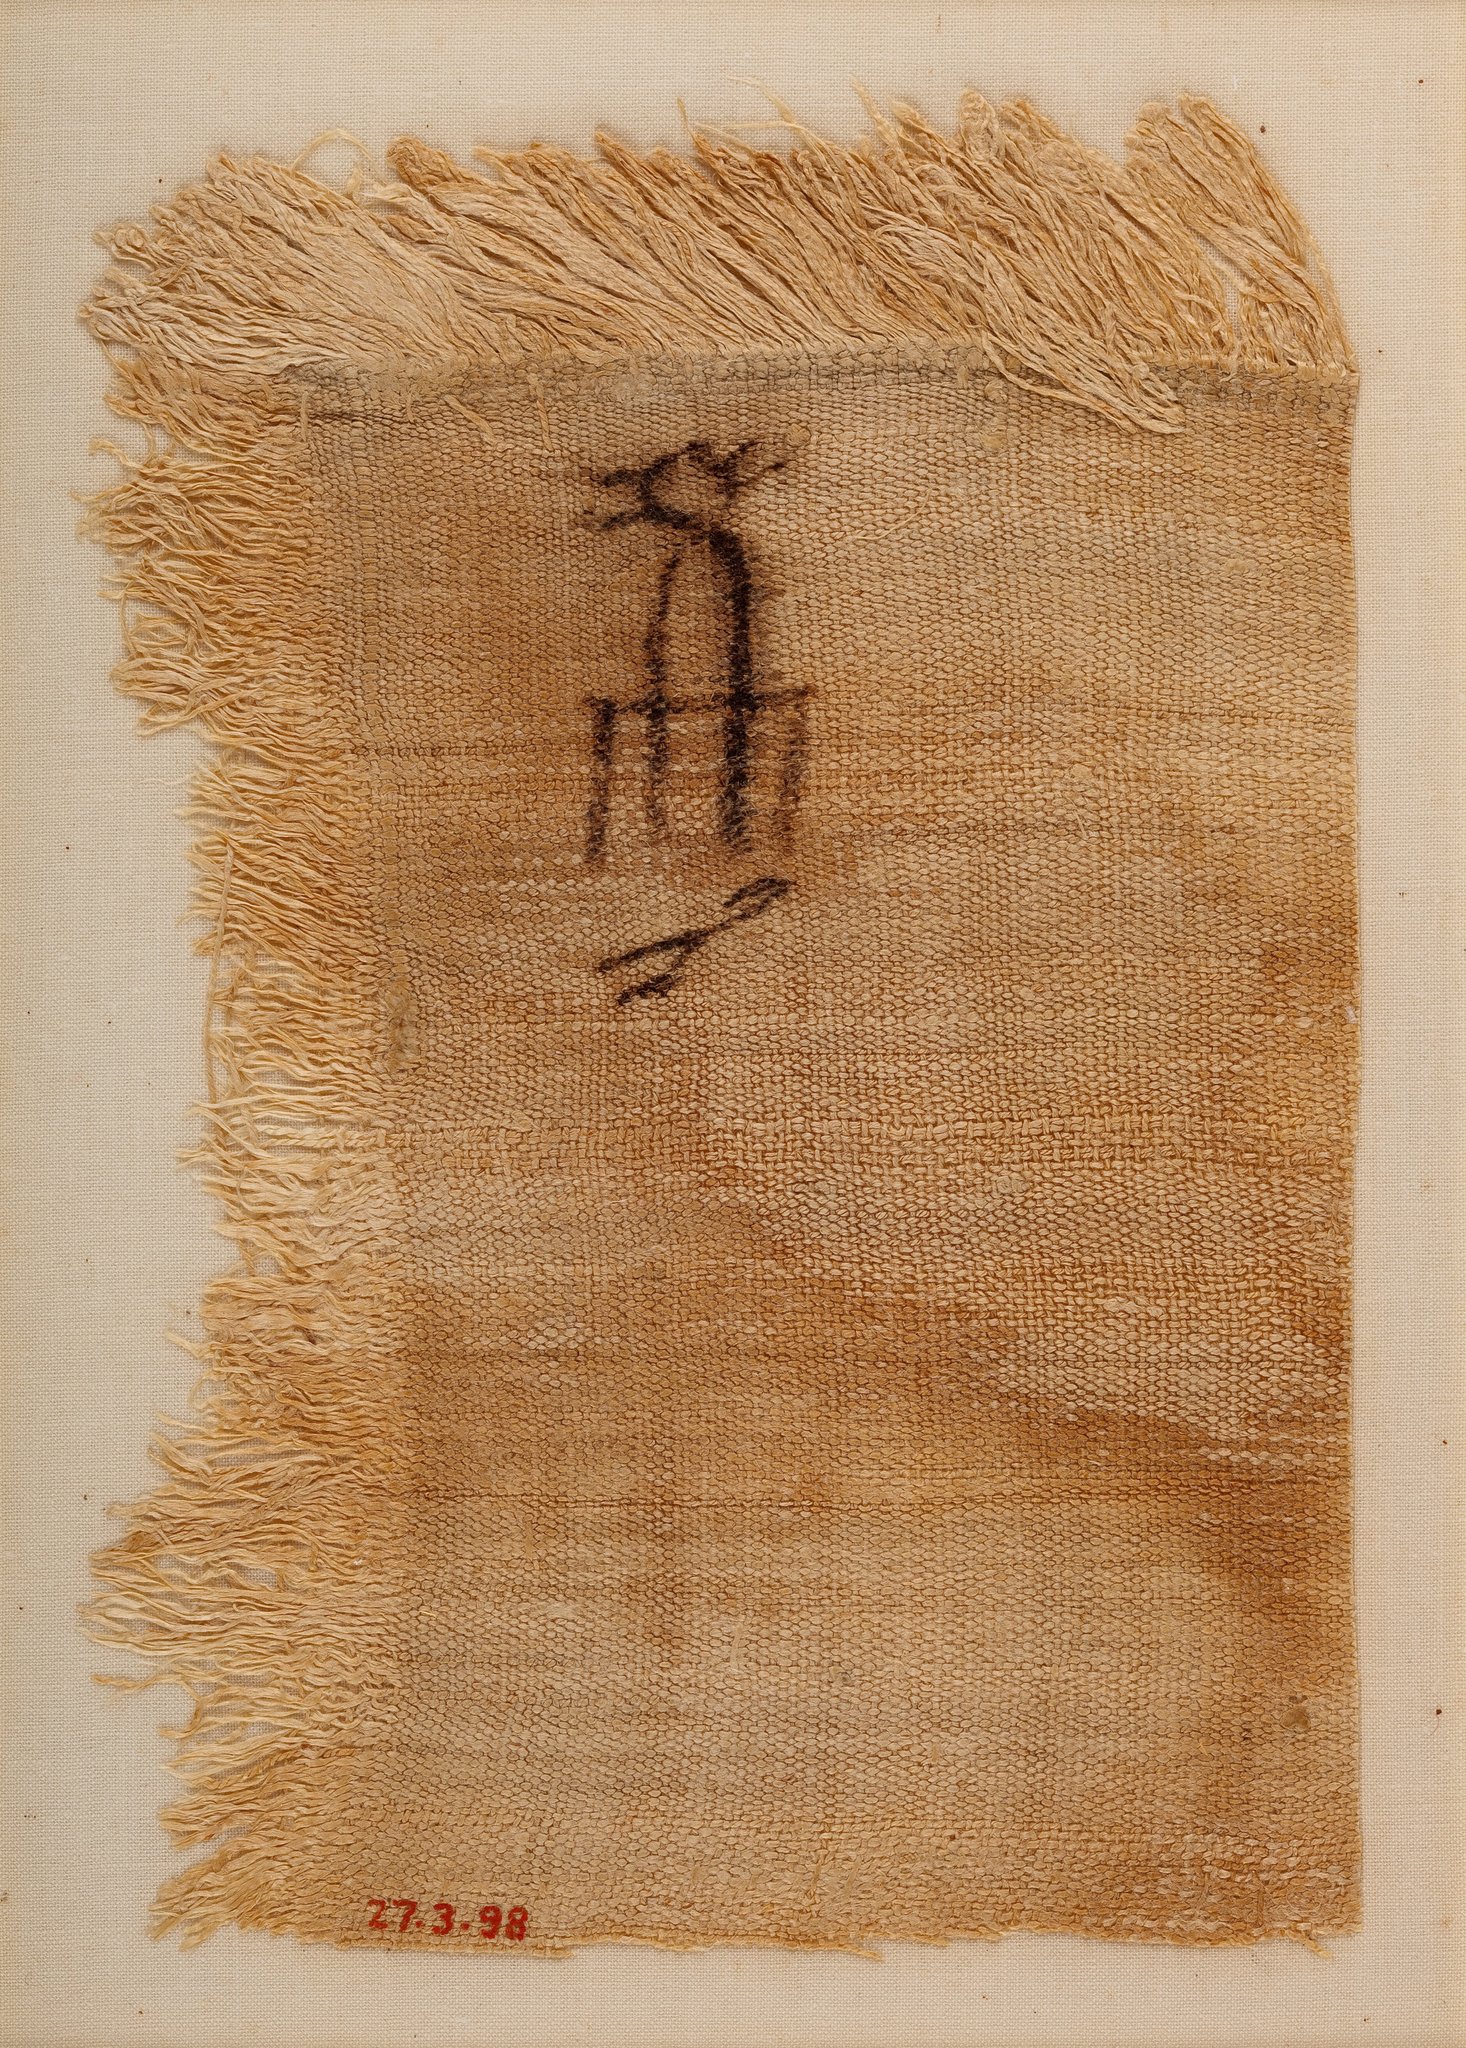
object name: linen mark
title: Linen mark (Type VI)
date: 1961-1917 BCE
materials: linen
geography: egypt